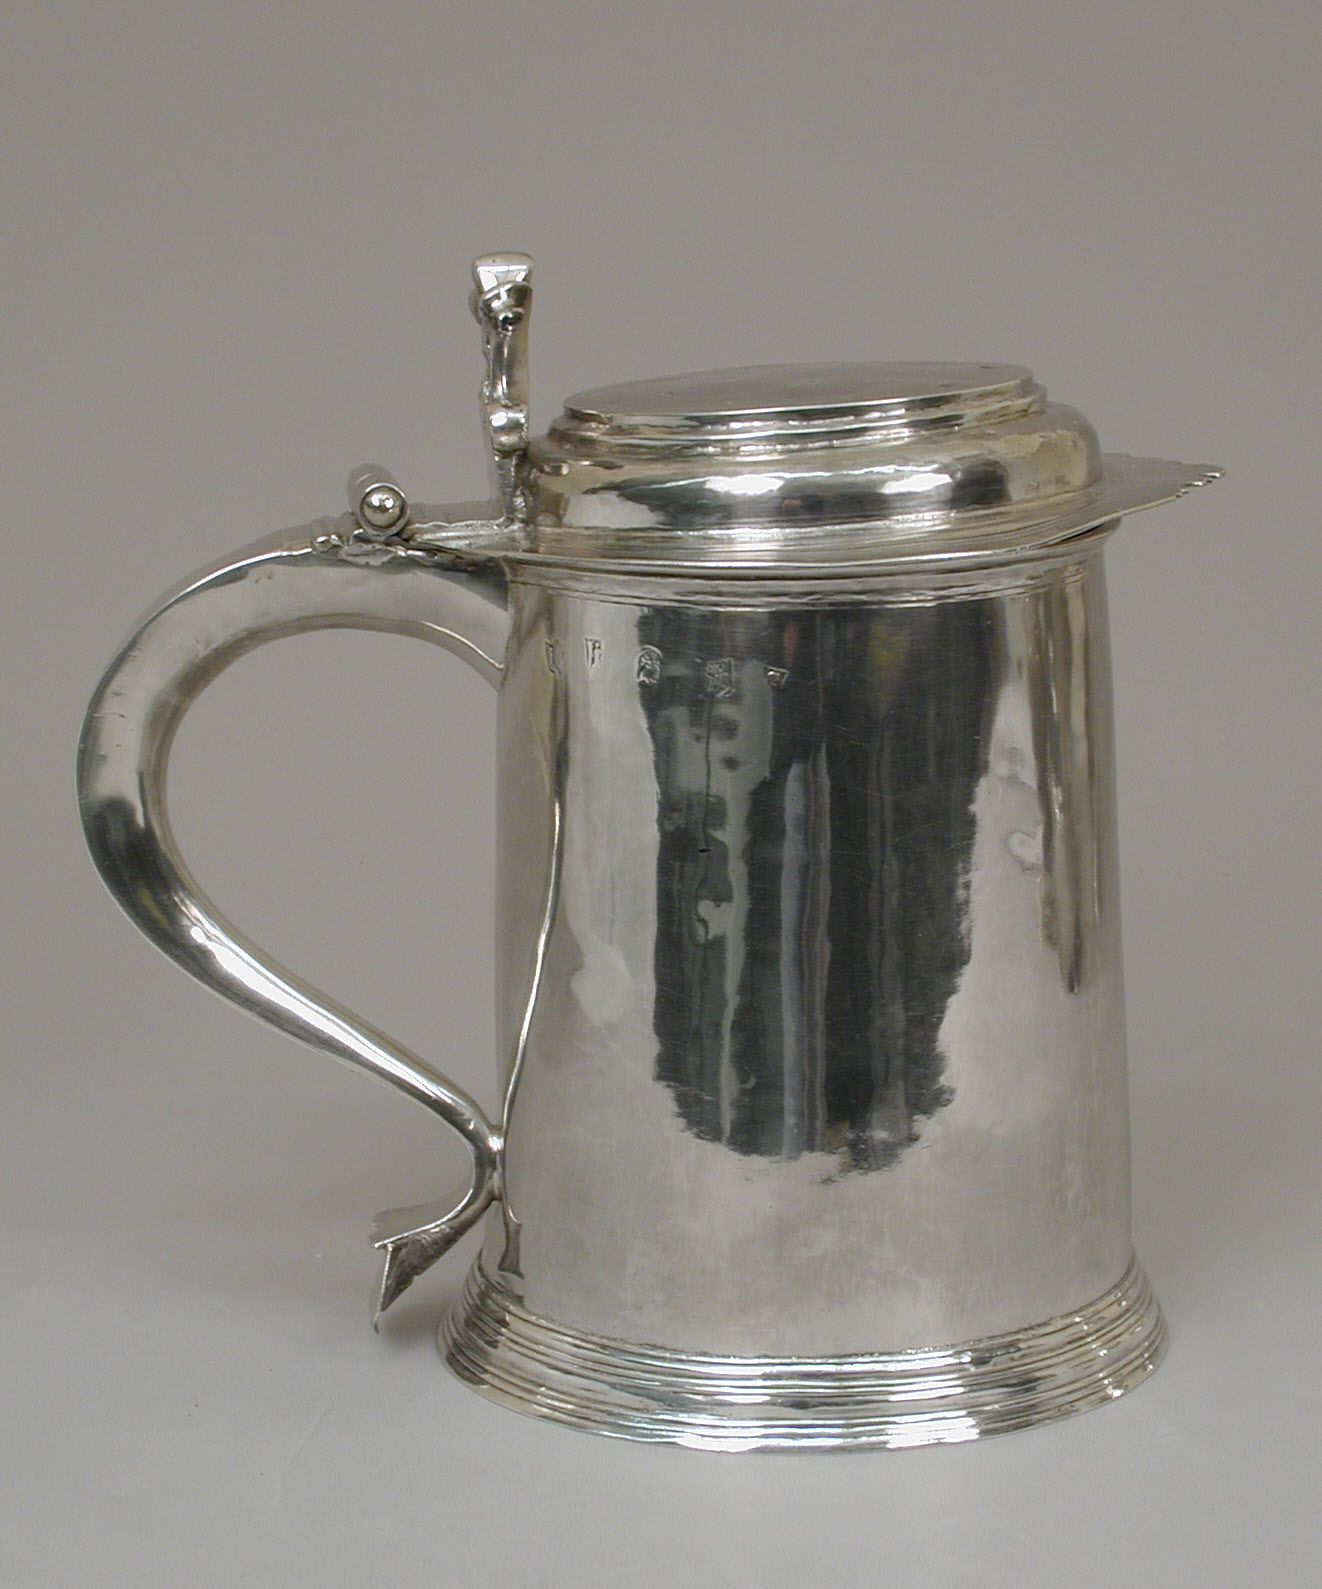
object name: peg tankard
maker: henry muston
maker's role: maker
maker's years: 1703-1704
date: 1703-1704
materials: silver